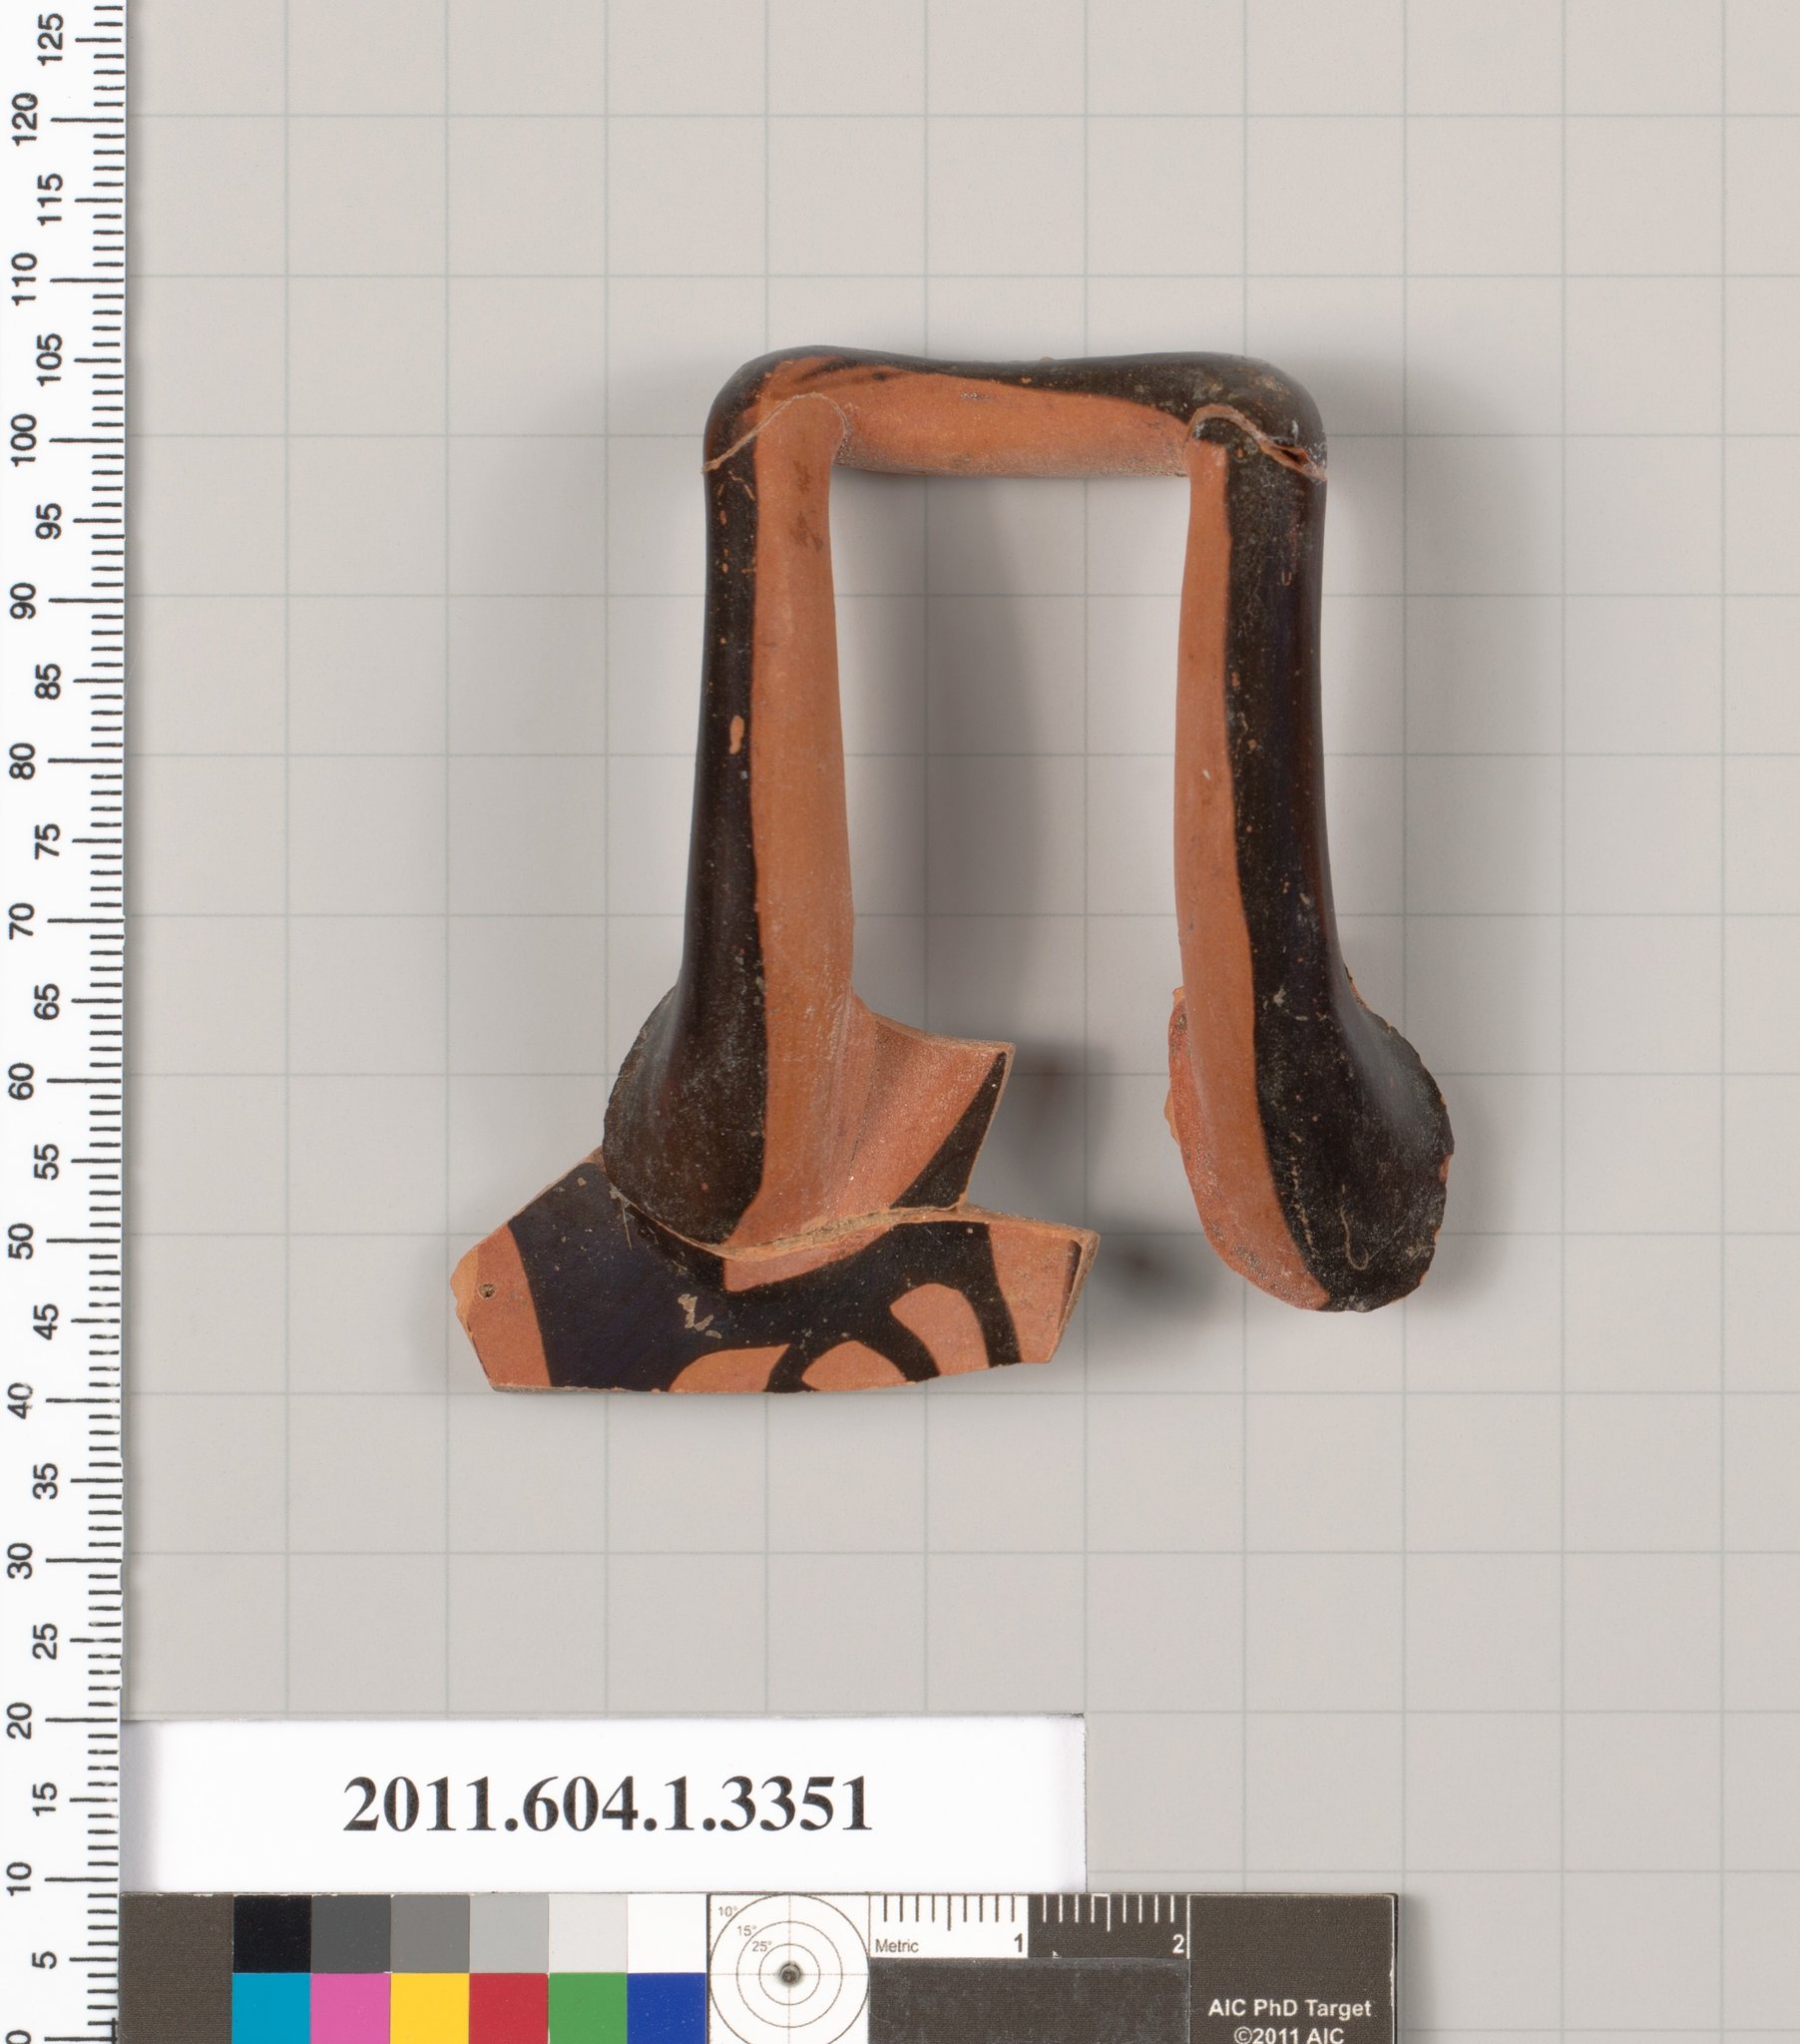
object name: kylix fragment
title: Terracotta fragment of a kylix (drinking cup)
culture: greek, attic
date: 467-435 BCE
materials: terracotta